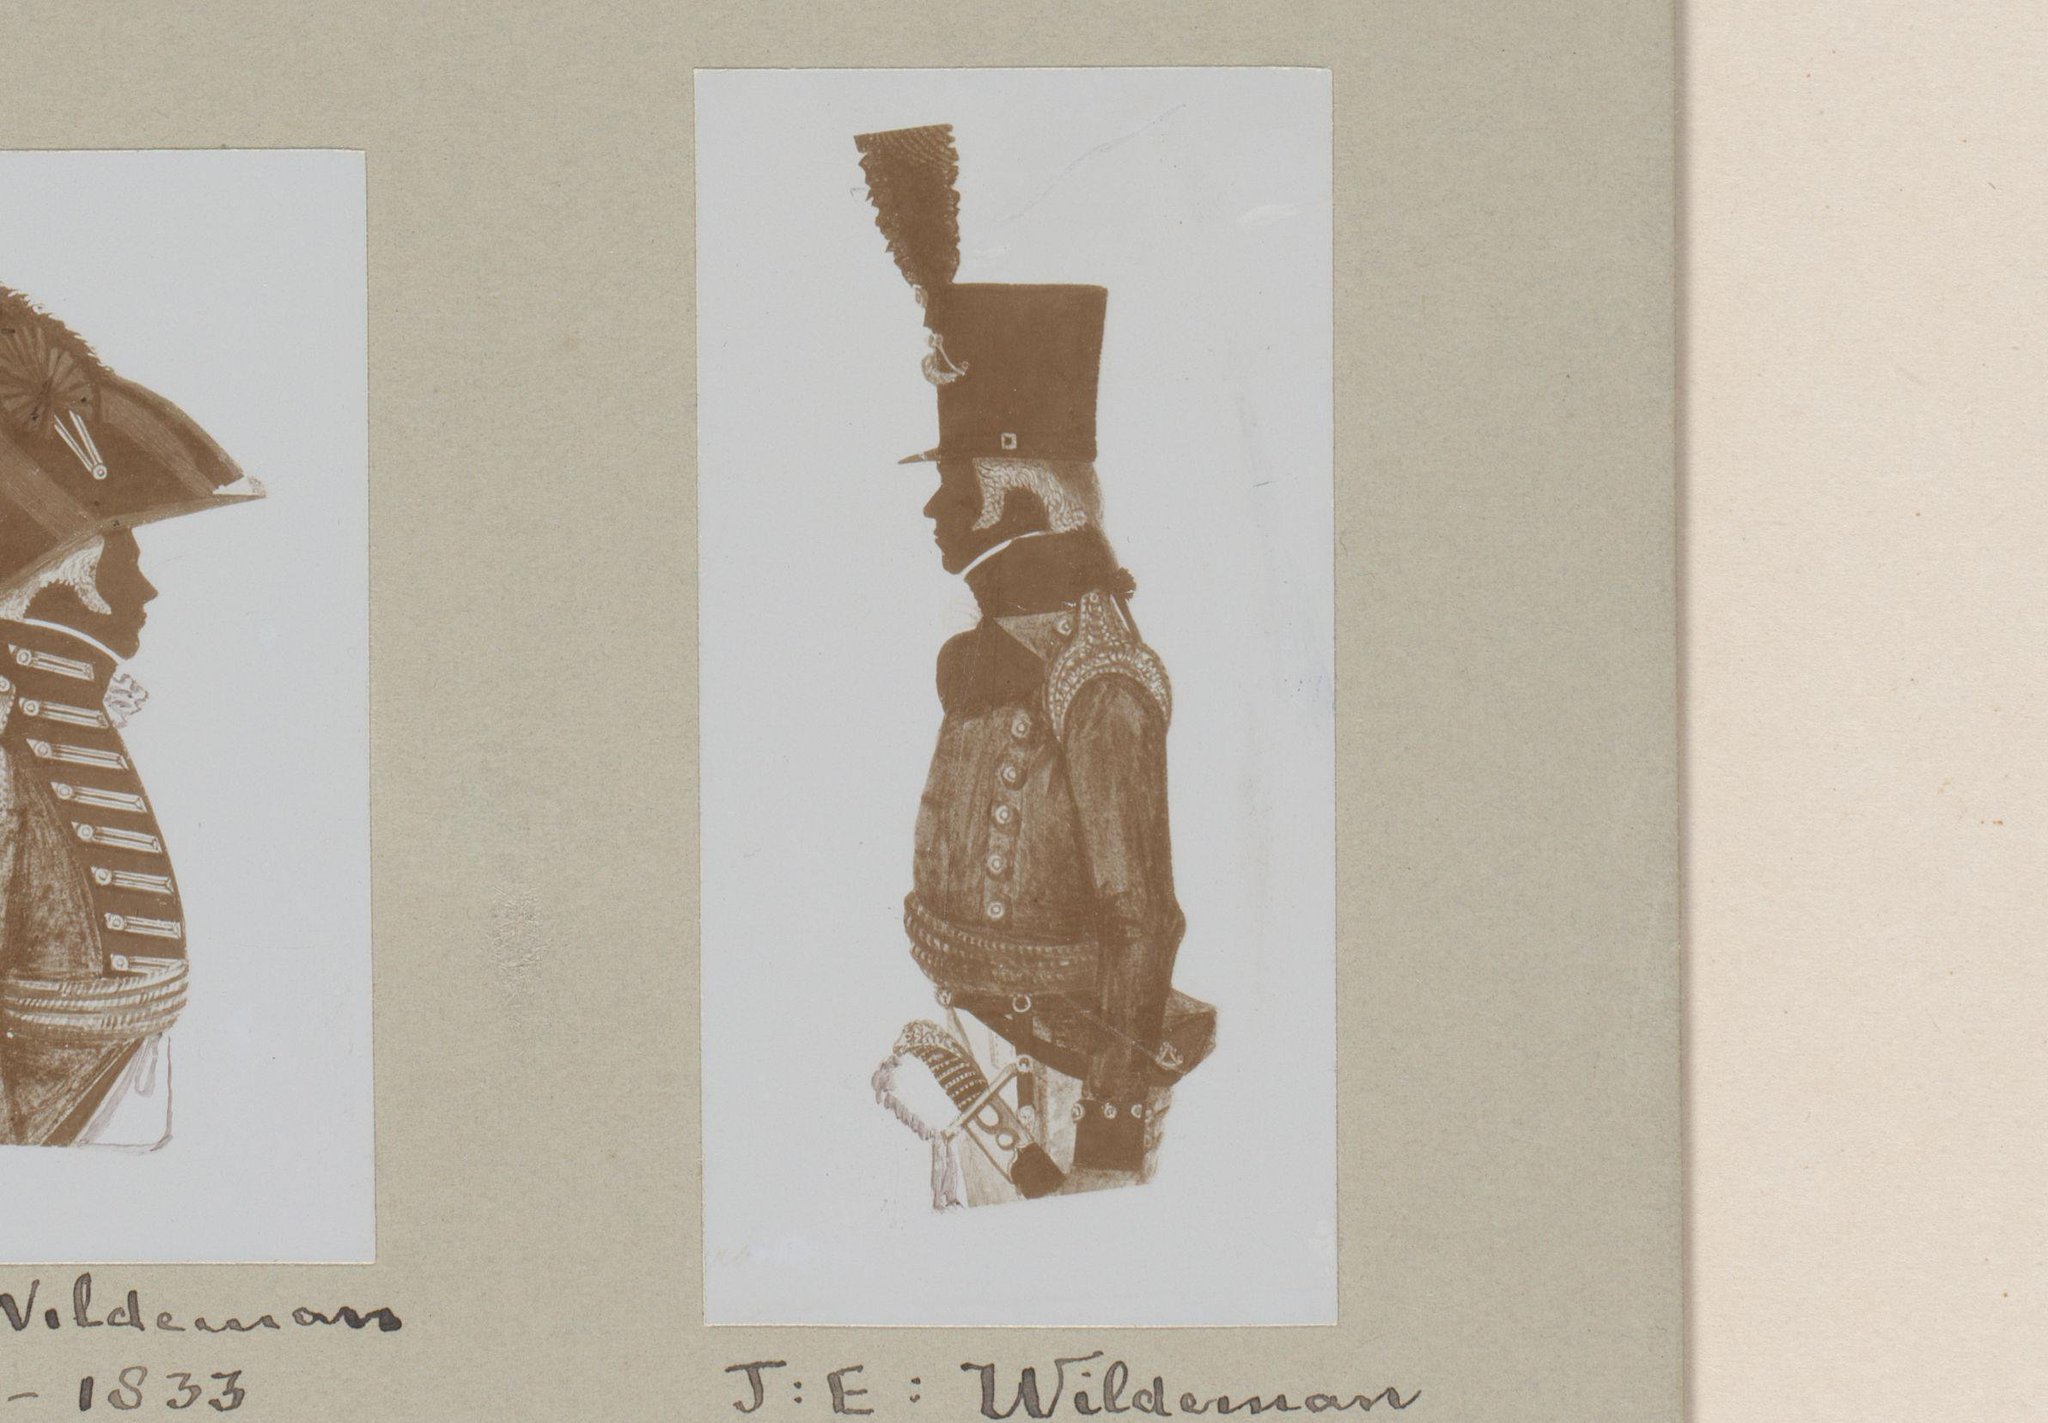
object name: photograph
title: Fotoreproductie van een silhouetteportret van Jan Ernst Wildeman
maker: Anonymous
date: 1880-1905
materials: paper, cardboard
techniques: collodion silver print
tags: harlingen, historical persons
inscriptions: inscription: ‘J:E: Wildeman/ 1770-1833/ als luit: der Jagers/ Holl: Brigade op/ Wight’, collector's mark: Lugt 2228